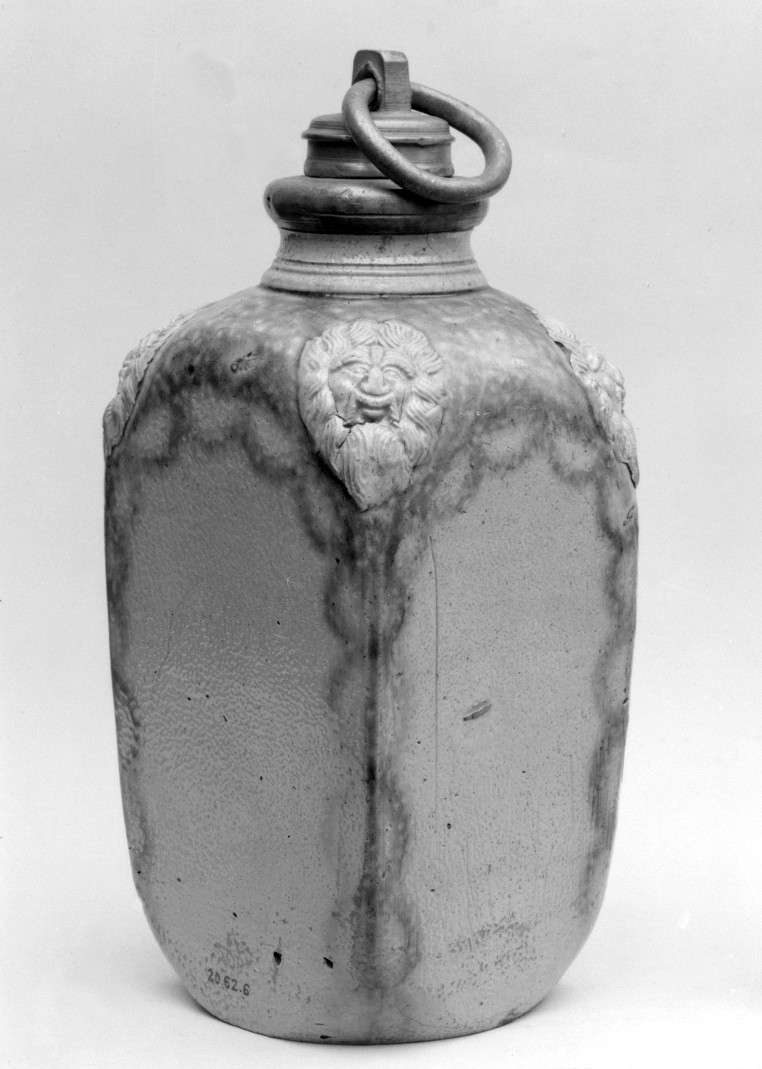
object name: jar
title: Screw-top jar (Schraubflasche)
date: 1701-1800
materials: pewter, stoneware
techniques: salt glaze